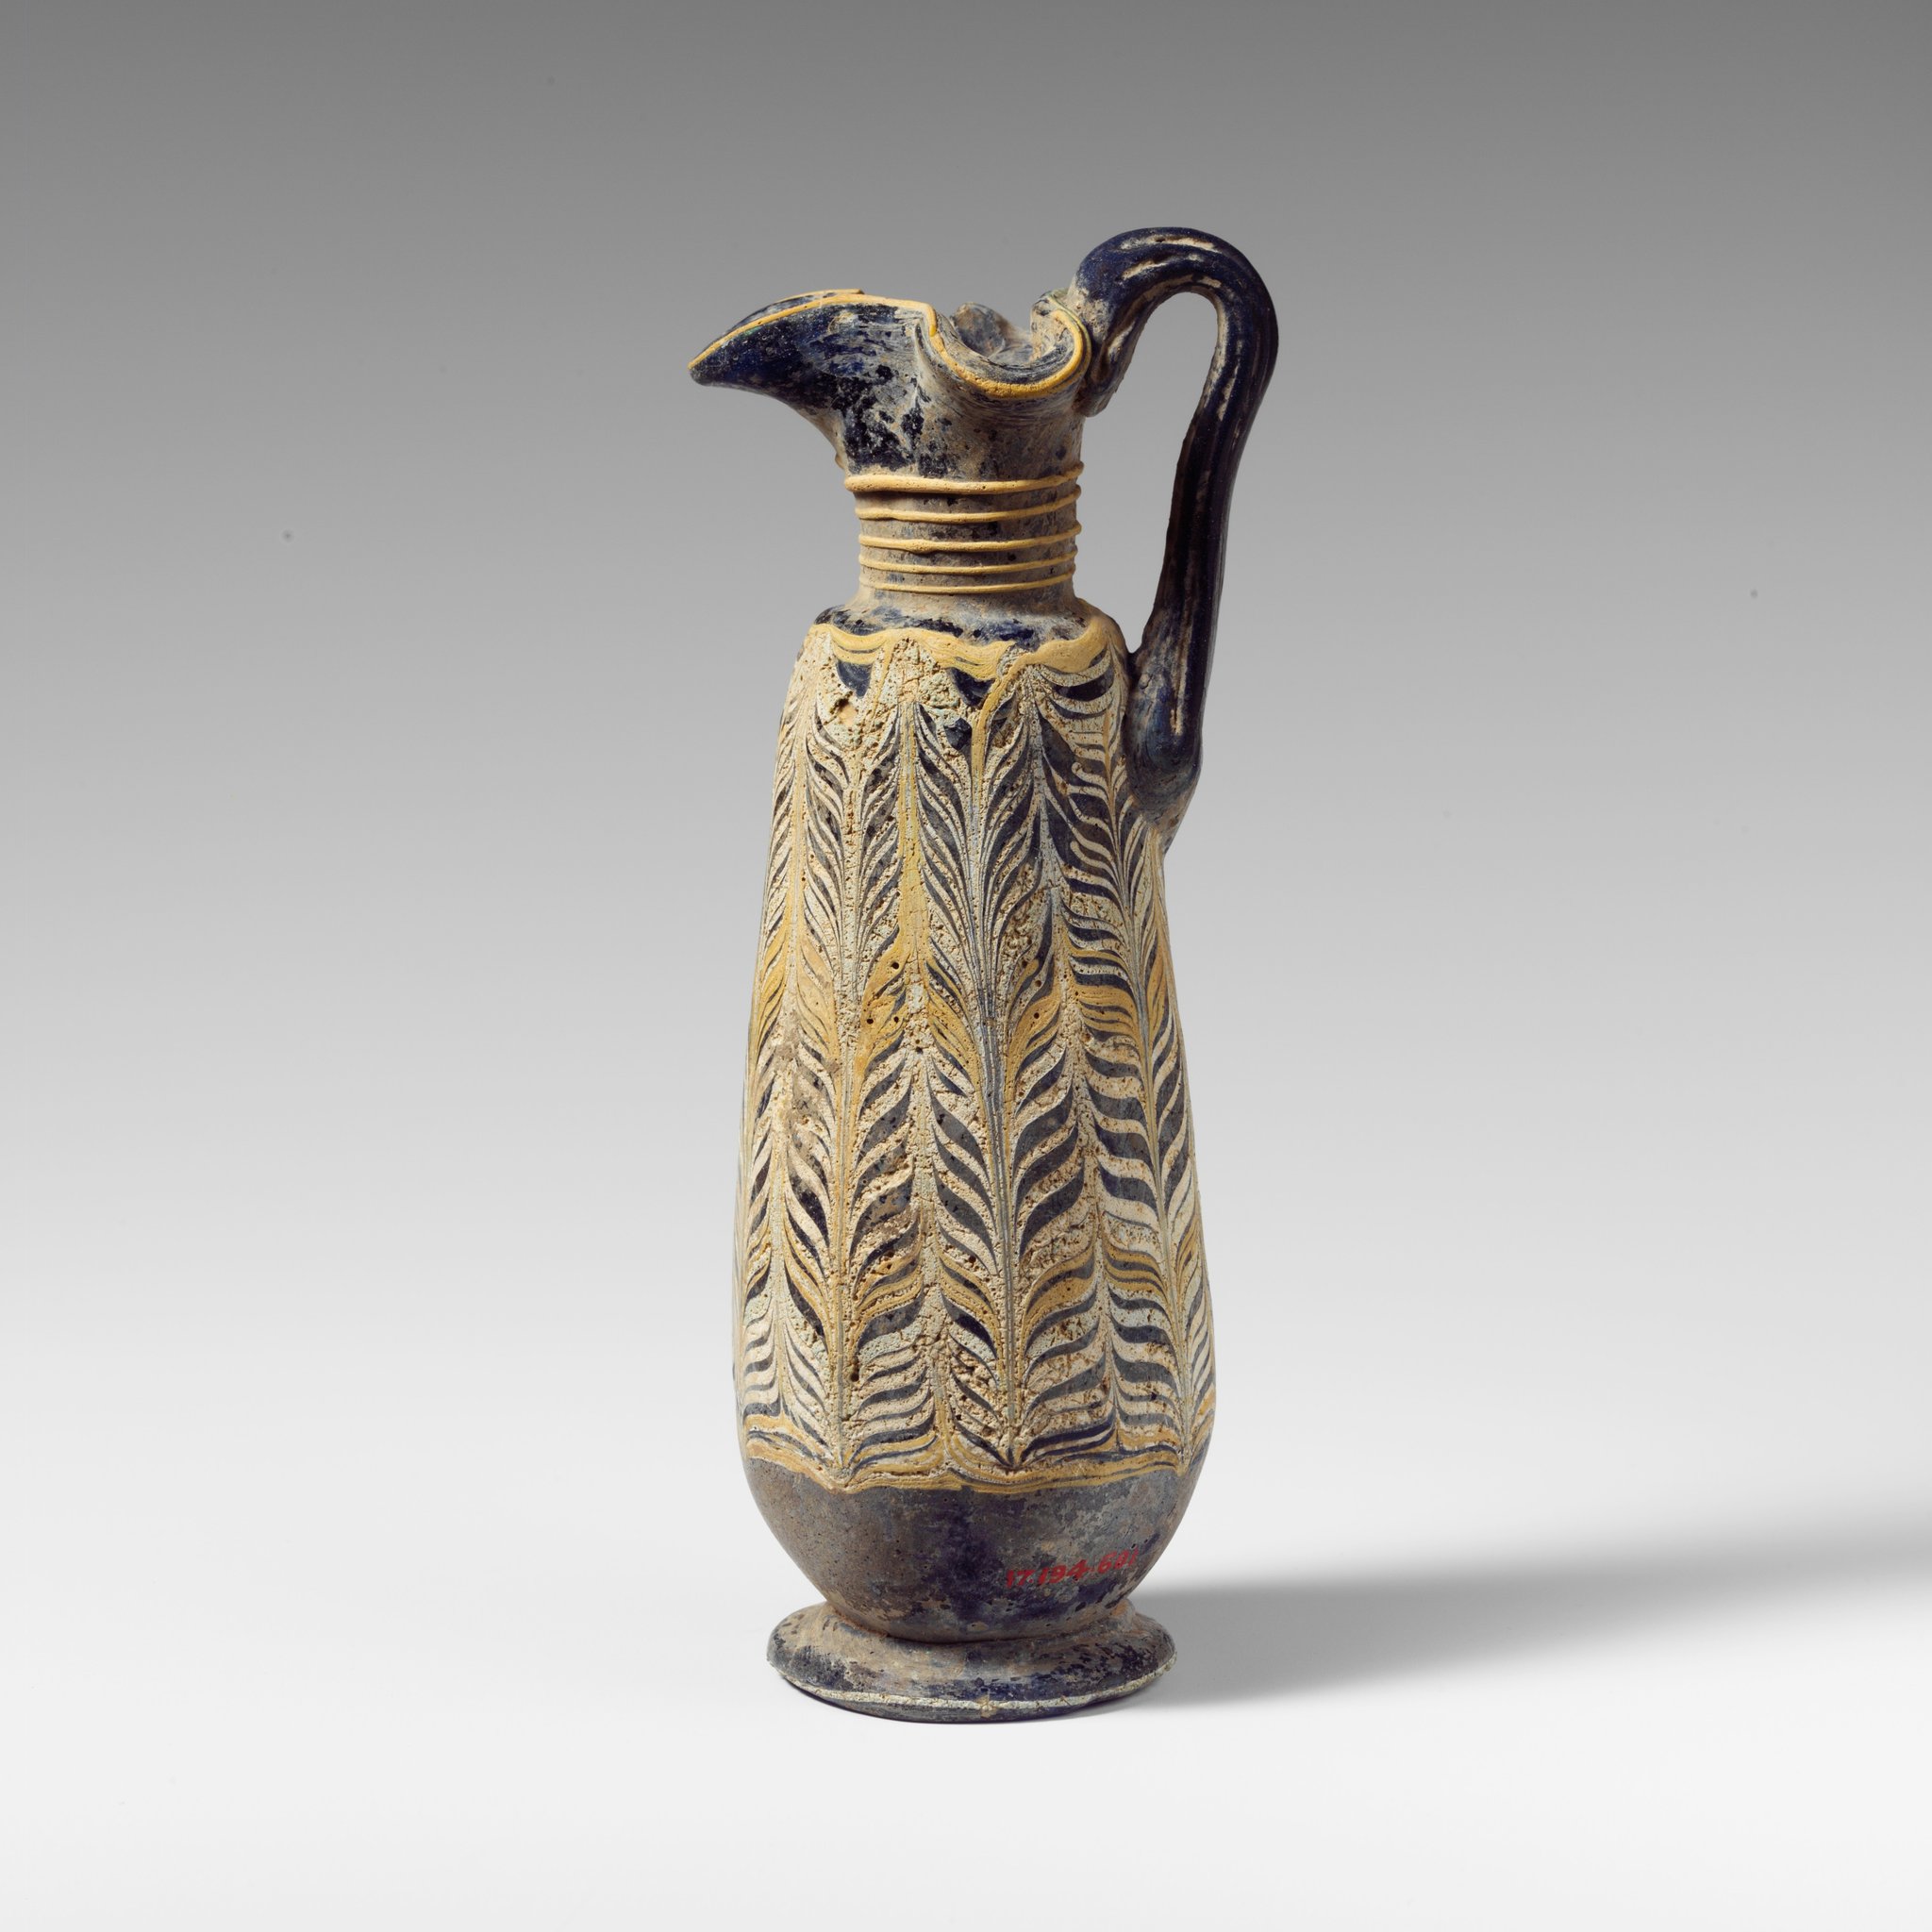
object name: oinochoe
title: Glass oinochoe (perfume jug)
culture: eastern mediterranean or south italian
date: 334-268 BCE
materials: glass